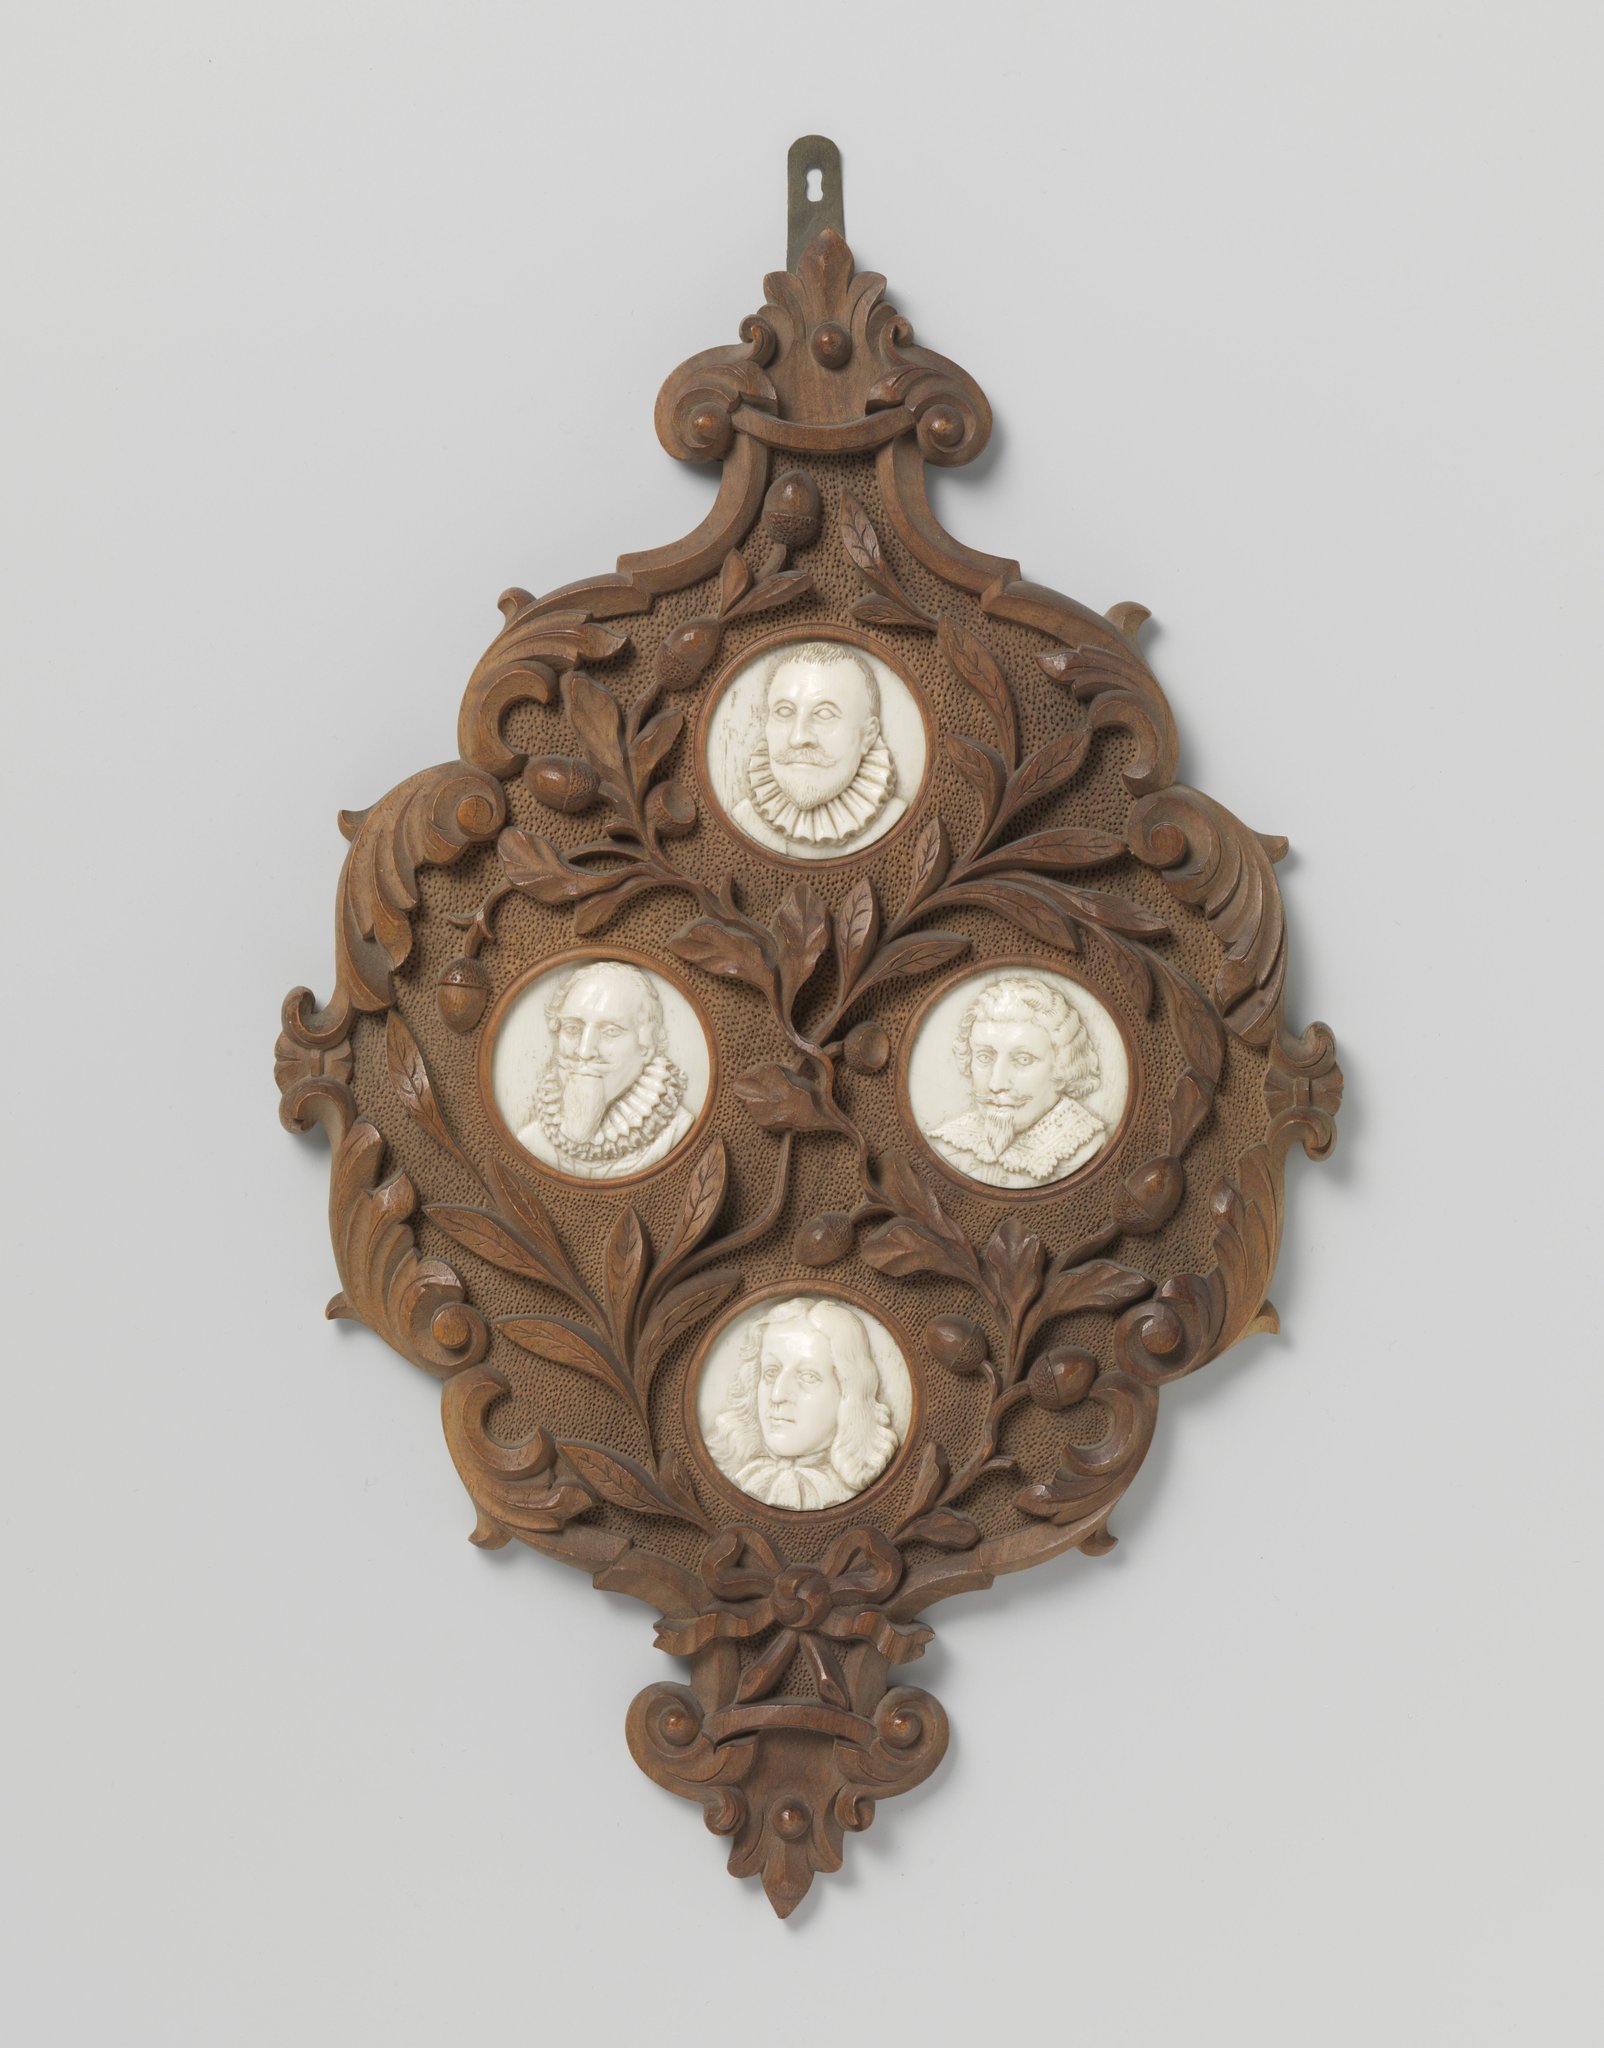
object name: sculpture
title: Decorative Frame with Four Portrait Medallions, Representing Stadholders William I (1533-1584), Maurice (1567-1625), Frederick Henry (1584-1647) and William III (1650-1701)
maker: Anonymous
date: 1850-1875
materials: ivory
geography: netherlands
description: Vier portretjes naar links, gevat in één lijst met eikeloof in reliëf op geponste grond en een rand van voluttvormige ranken en cartouchevormige uiteinden boven en onder. 5. Willem I, prins van Oranje (1533-1584). In de achterkant gegraveerd 'Saevis tranquillus in undis' 6. Maurits, prins van Oranje (1567-1625). In de achterkant gegraveerd 'Je maintiendray Nieuwpoort 2 July 1600 7. Frederik Hendrik, Prins van Oranje (1584-1647). In de achterkant gegraveerd 'En Hendrick houdt de heirbaan van August. En sluit de poort van 't gruwelijk oorlogh toe' 8. Willem III, Prins van Oranje (1650-1701). In de achterkant gegraveerd 'Nu ziet ge uw rechten en uw wetten, o Britten onverwrikbaar zetten Oranje zijn aan boord!'